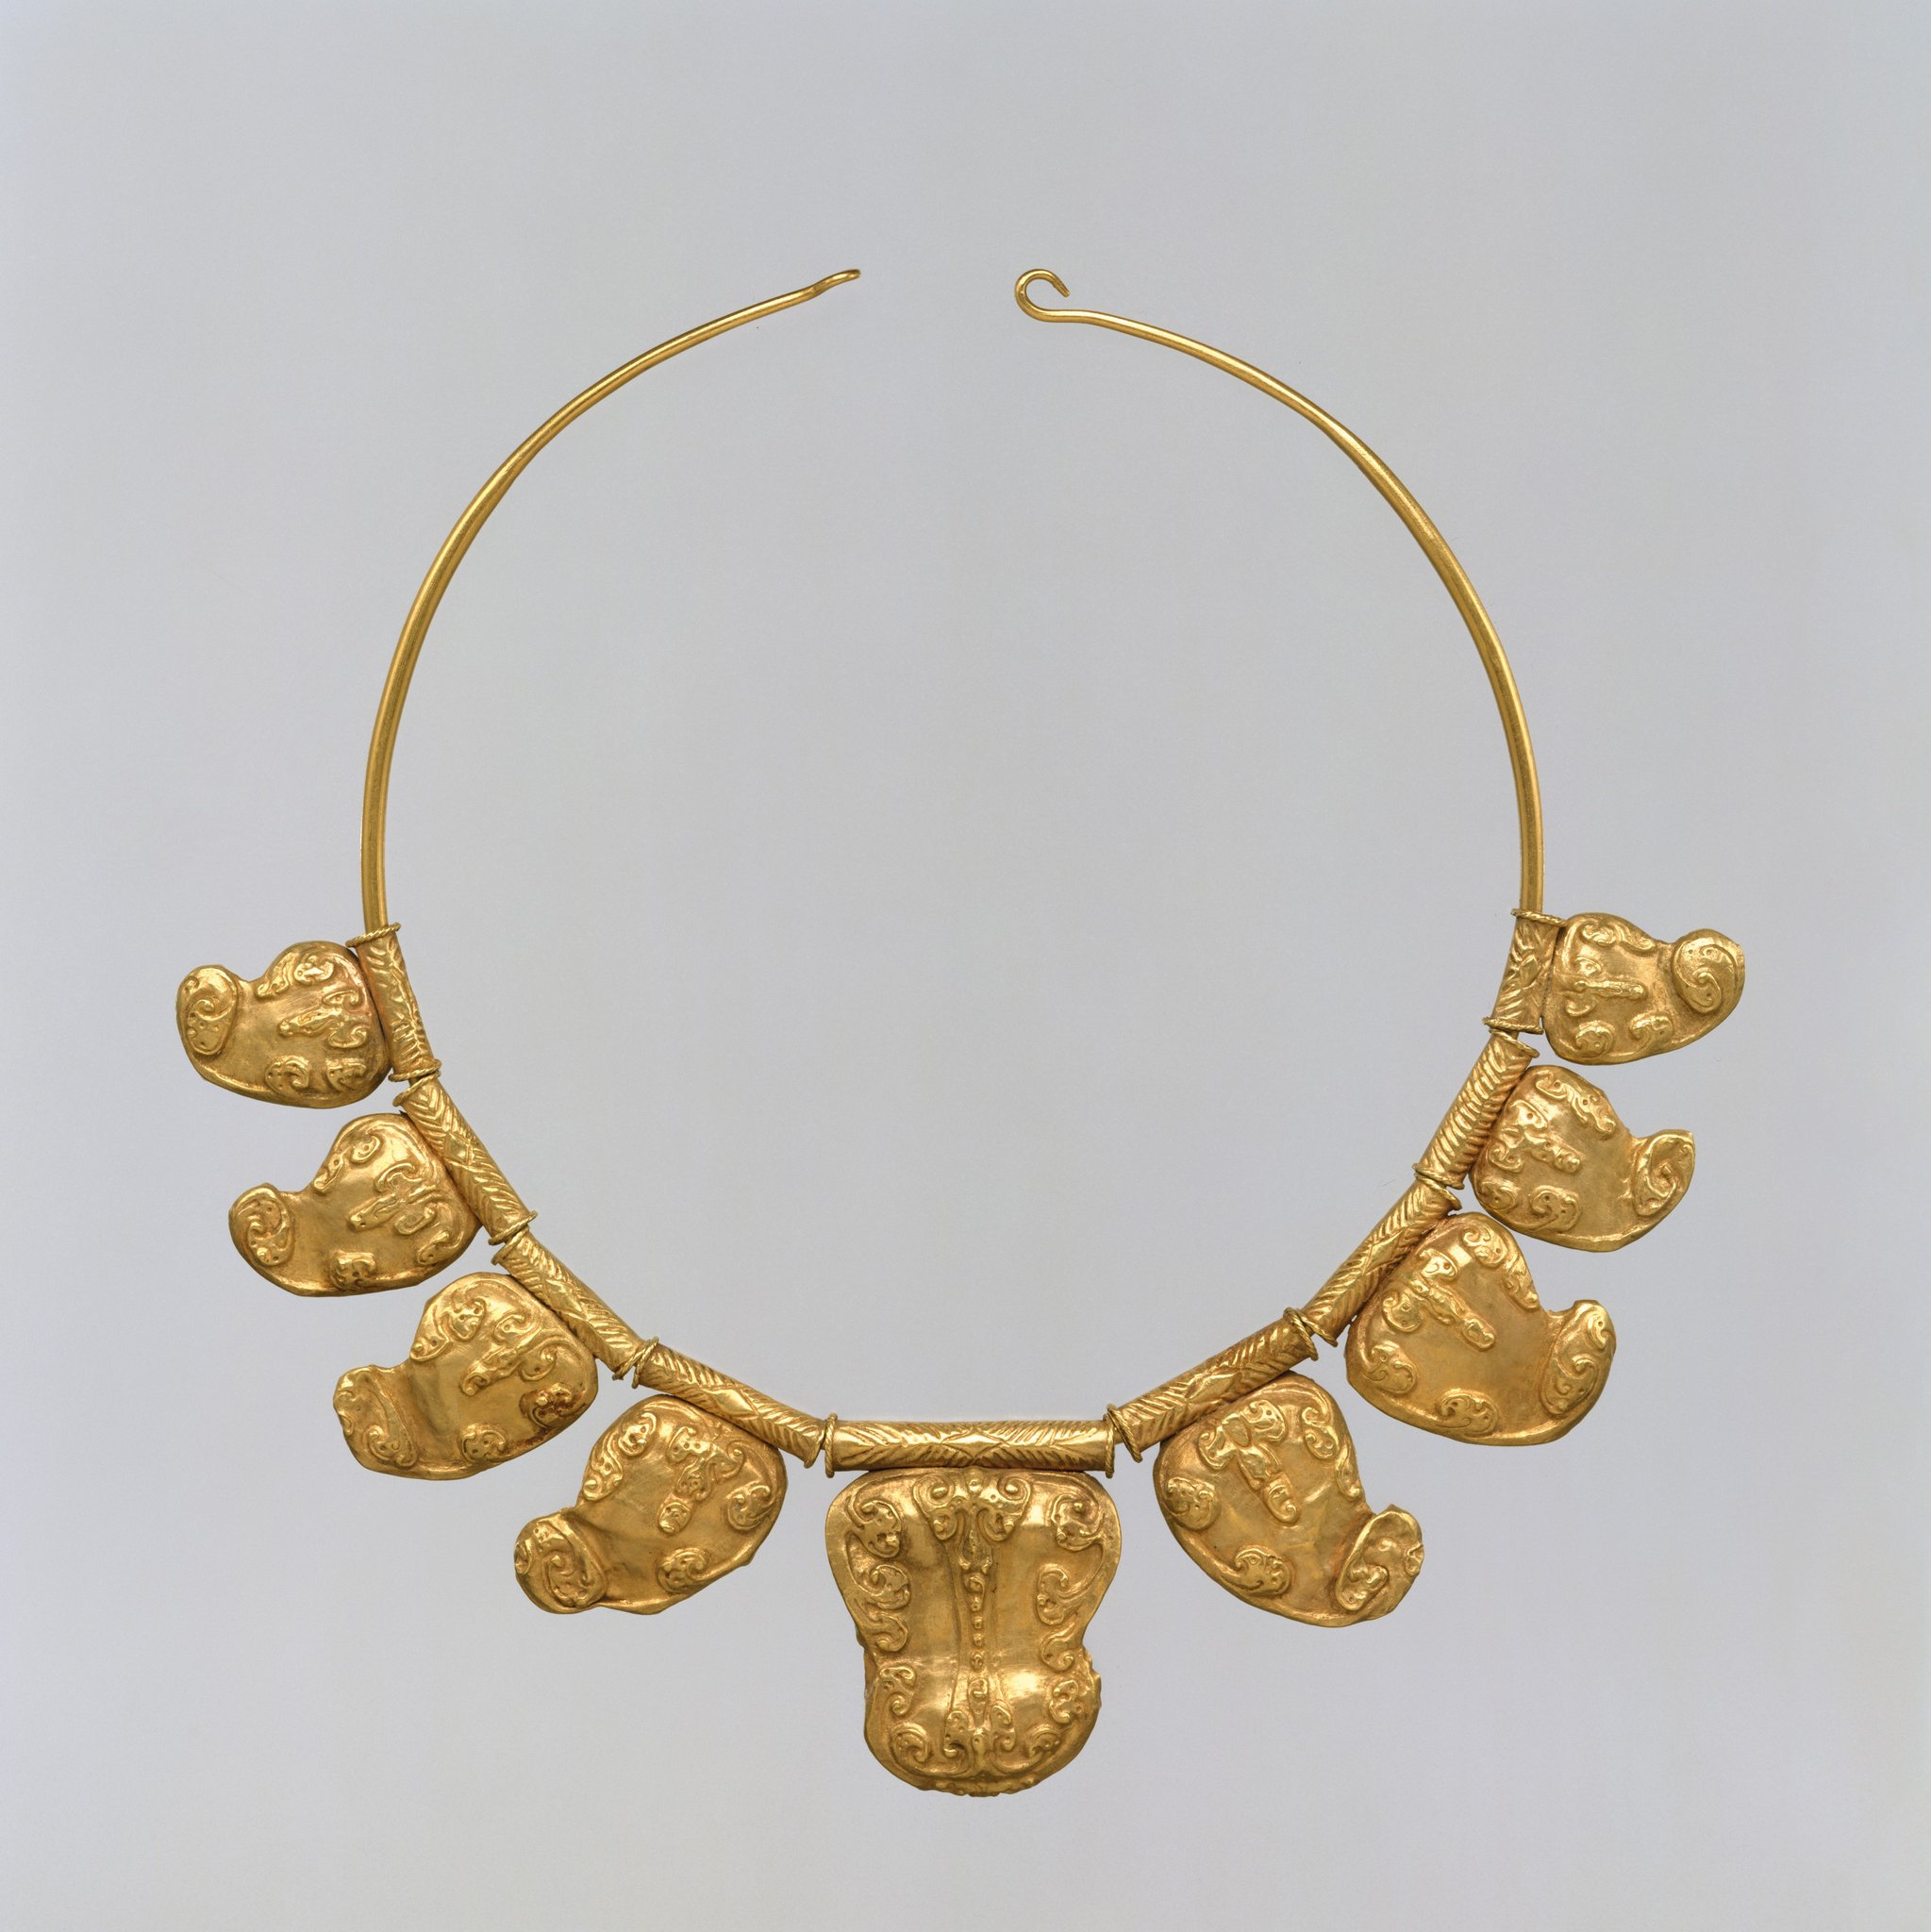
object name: necklace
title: Tiger's Claw Necklace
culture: indonesian, central java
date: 701-1200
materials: gold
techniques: repoussé